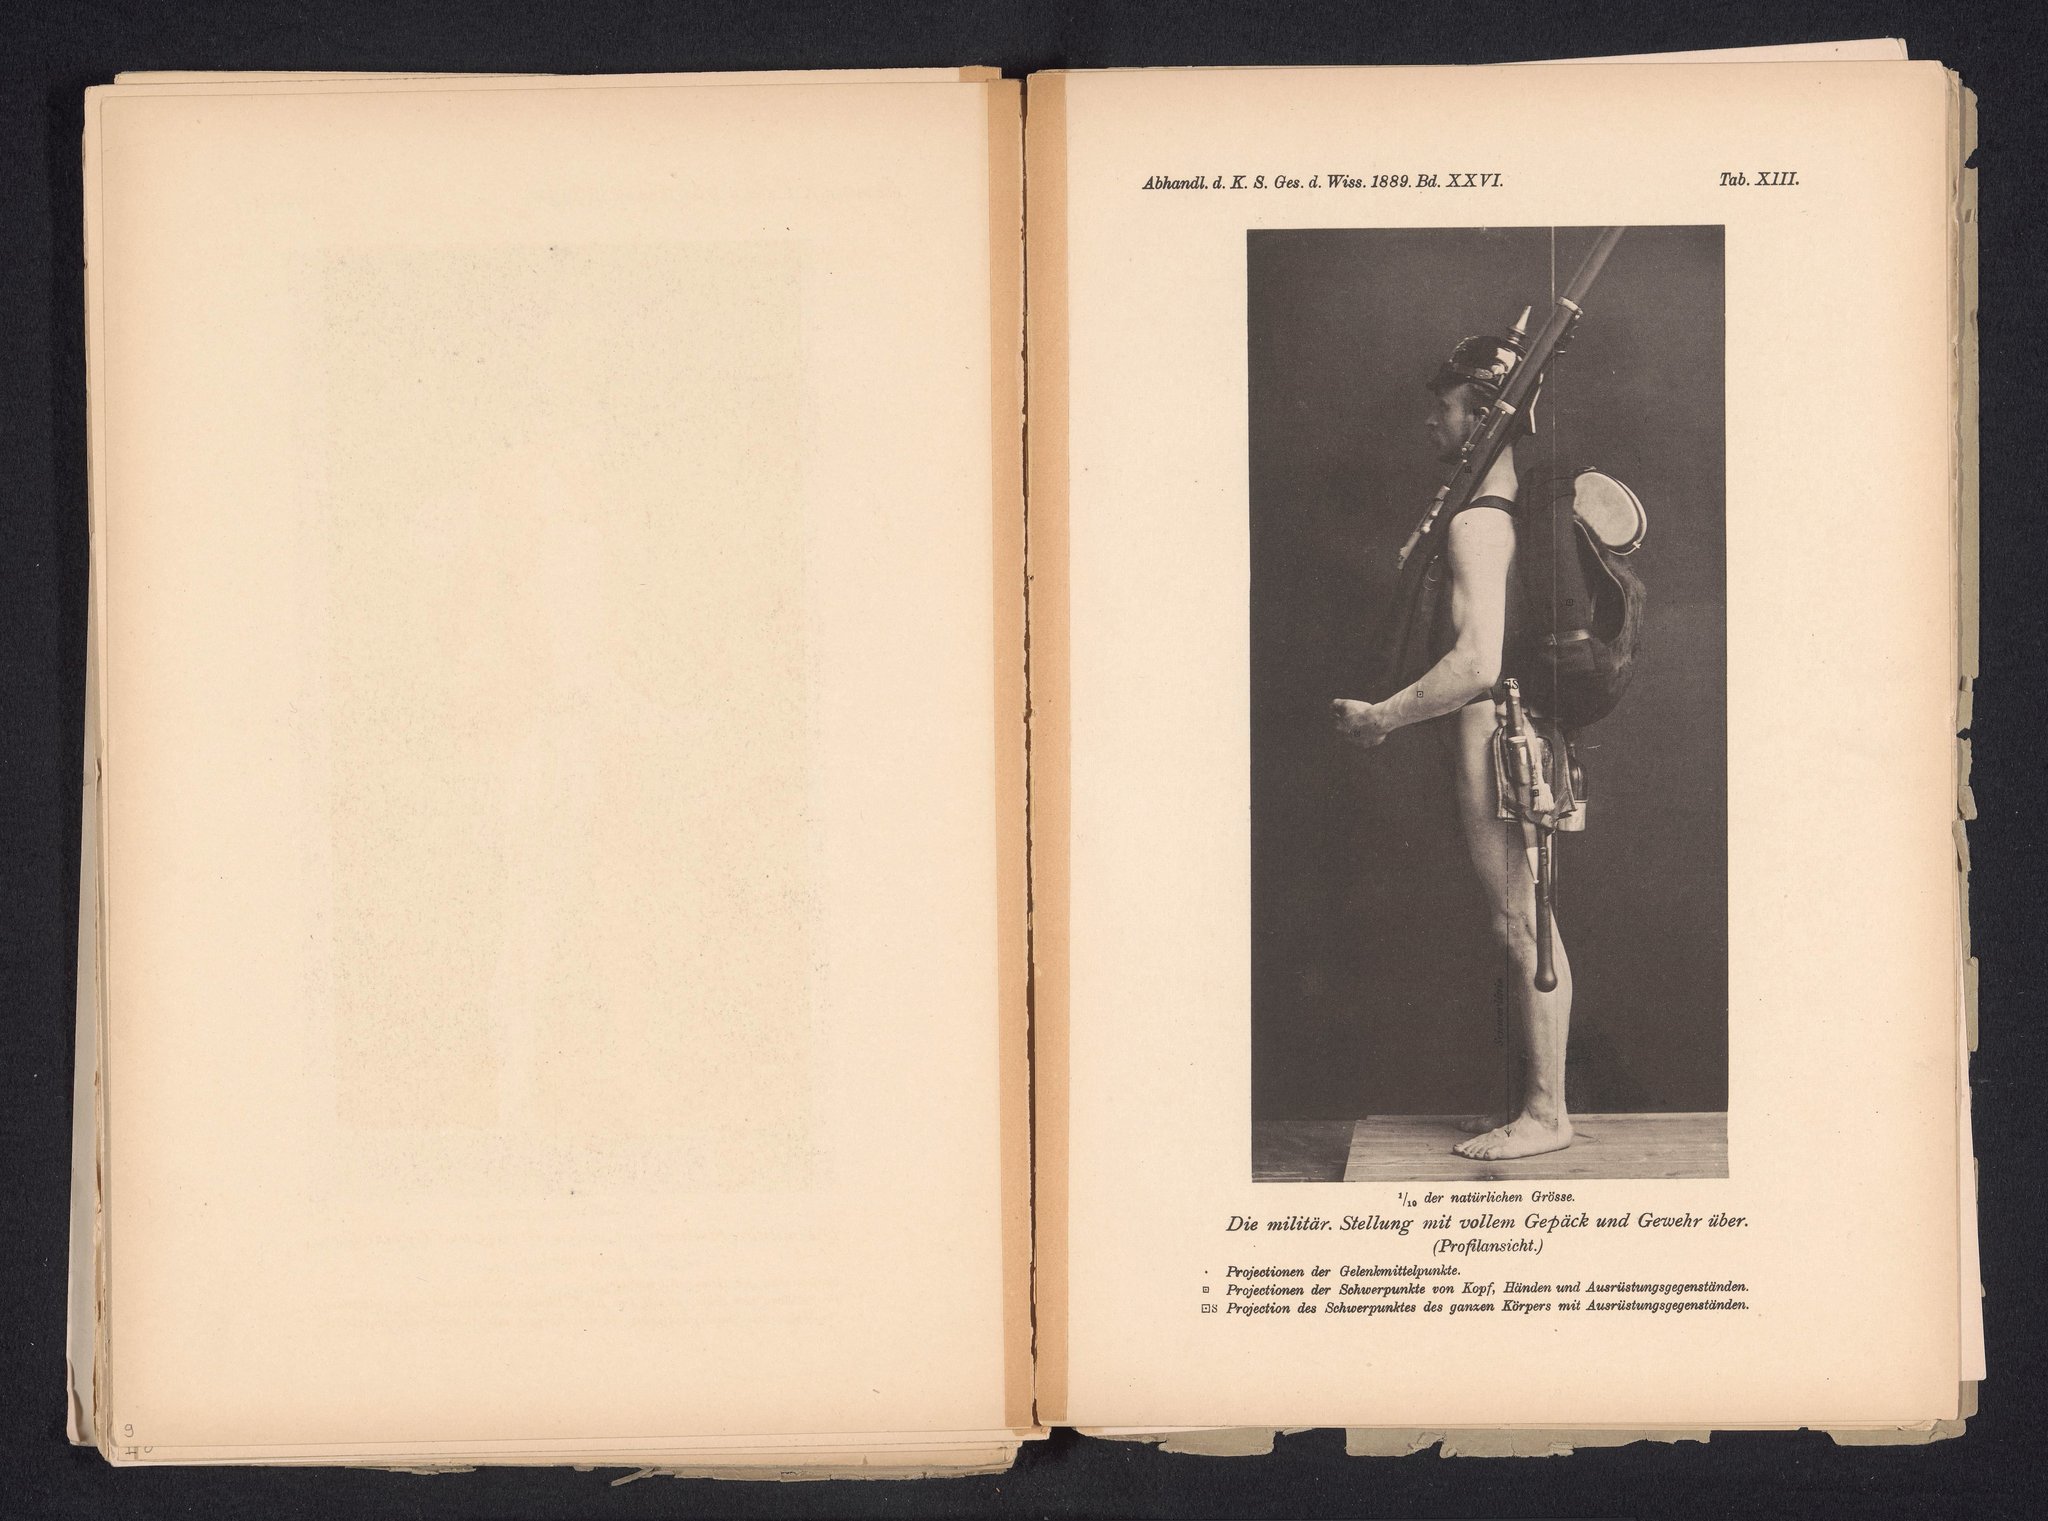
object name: photomechanical print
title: Onbekende naakte man, en profil met een geweer en militaire bepakking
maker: Anonymous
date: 1880-1890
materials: paper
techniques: photograph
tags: anatomy (non-medical), firearms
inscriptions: inscription: ‘Schwerlinie. 1/10 der natürlichen Grösse. Projectionen der Gelenkmittelpunkte. Projectionen der Schwerpunkte von Kopf, Händen und Ausrüstungsgegenständen. Projection des Schwerpunkte des ganzen Körpers mit Ausrüstungsgegenständen.’, number: ‘Tab. XIII.’